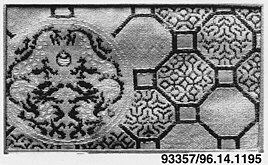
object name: piece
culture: japanese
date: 1701-1900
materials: silk